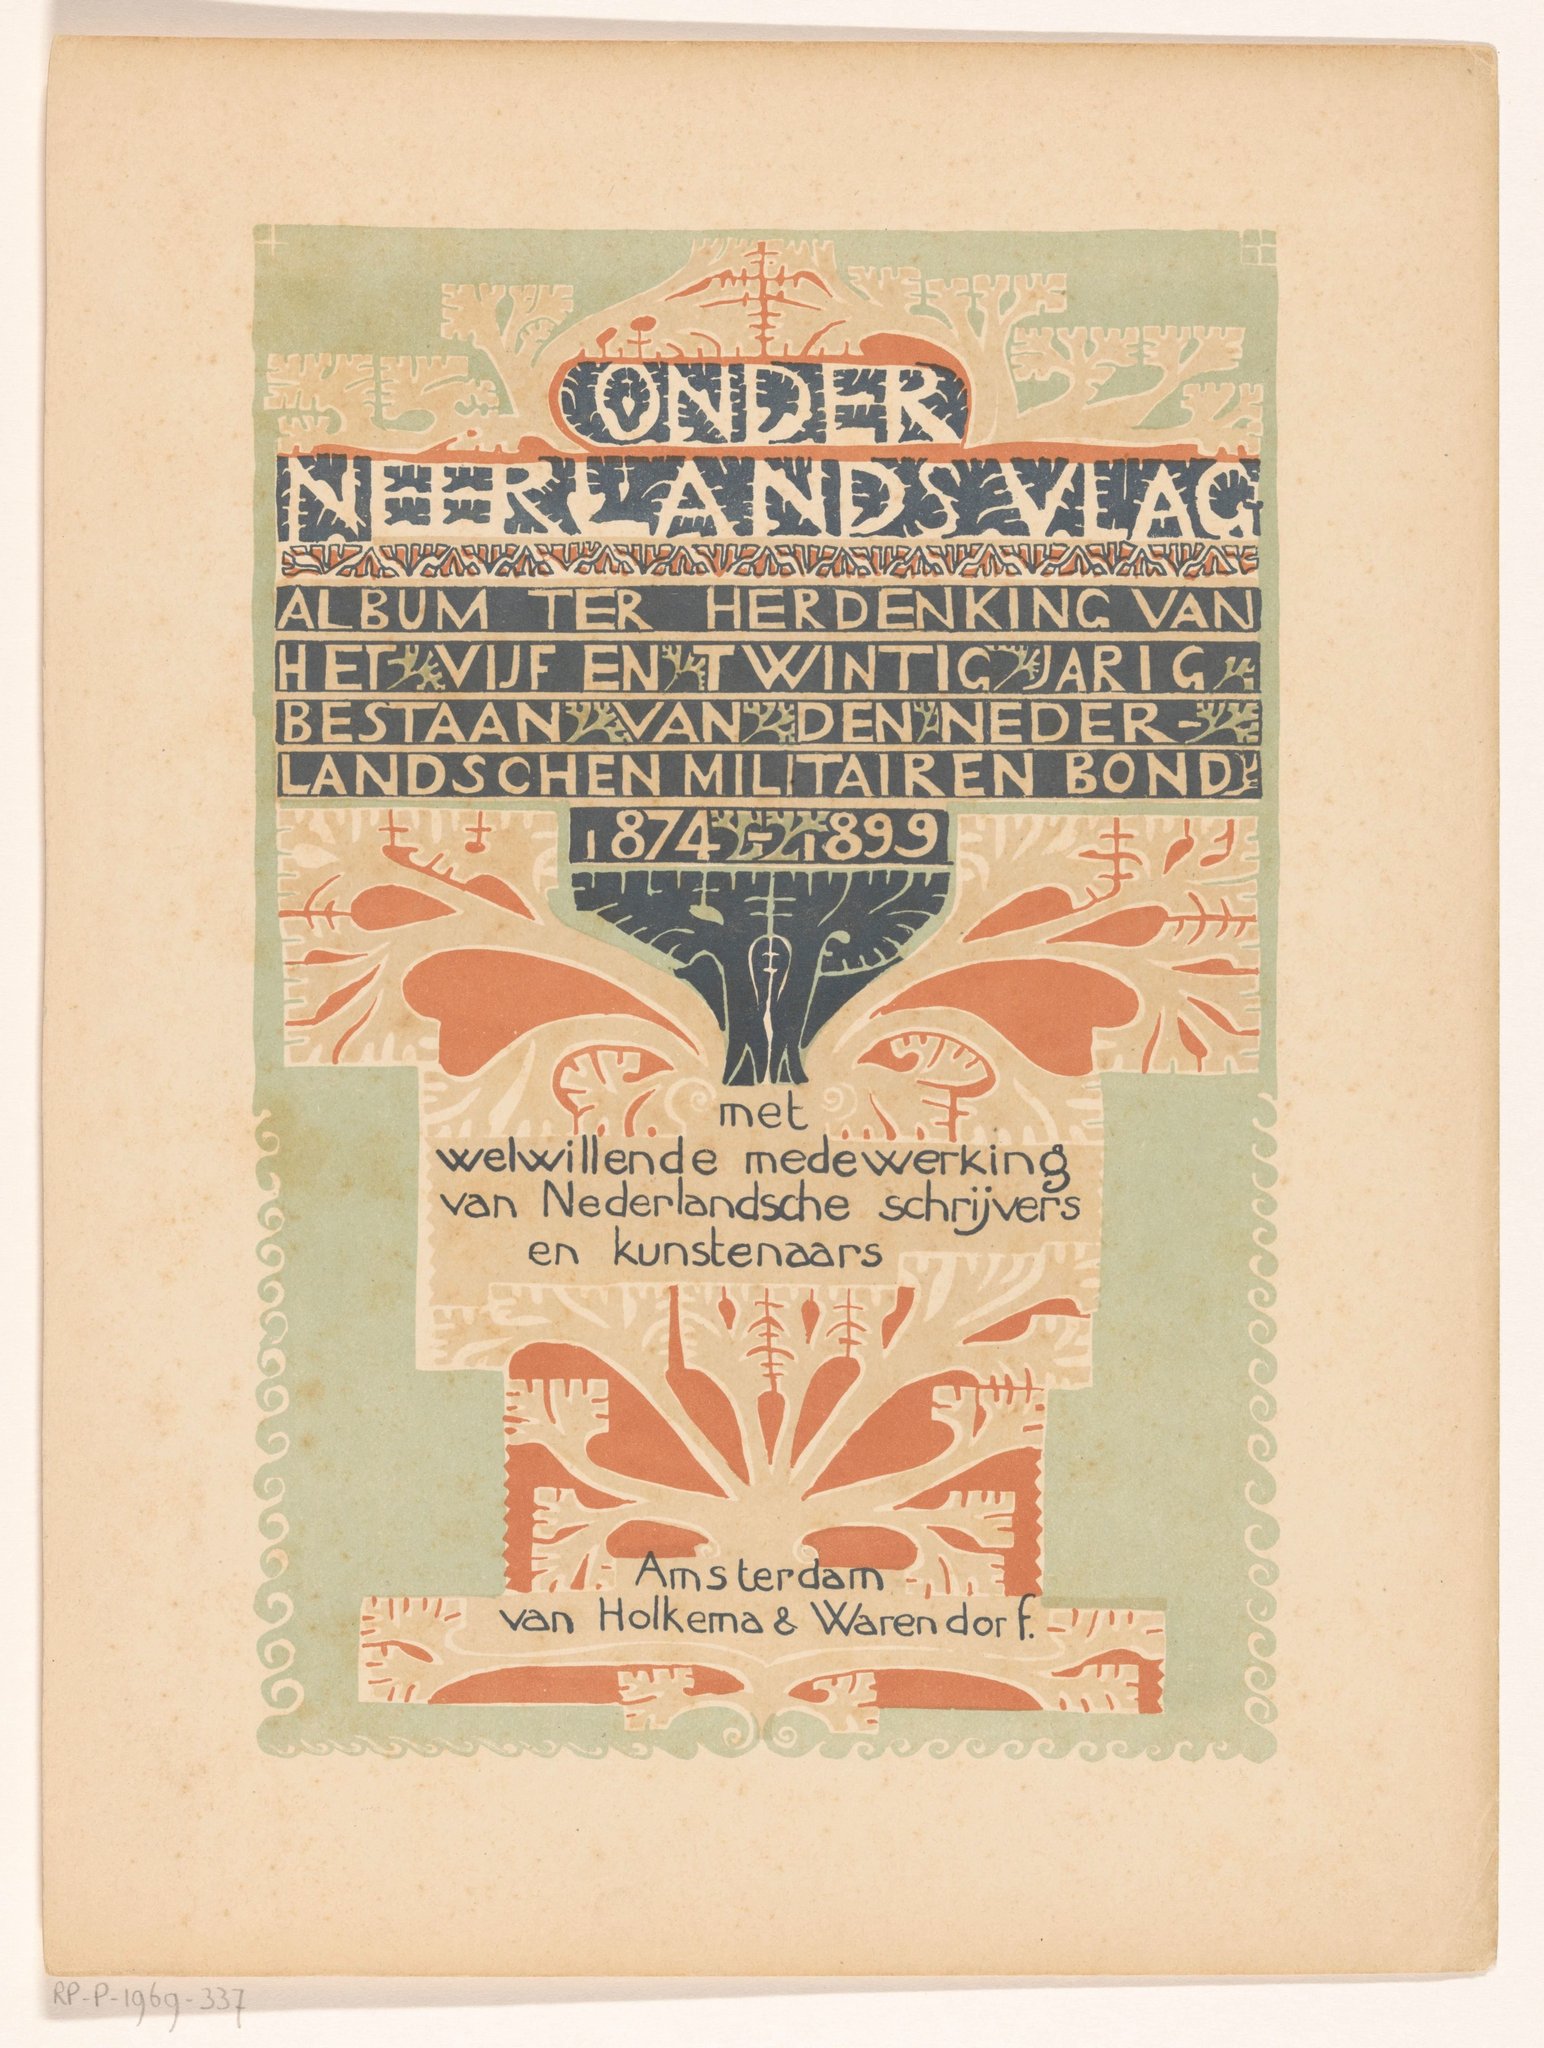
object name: print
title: Titelpagina voor: Onder Neerlands vlag, 1899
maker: carel adolph lion cachet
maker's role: draughtsman, print maker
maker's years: 1864-1945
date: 1899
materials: paper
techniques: lithograph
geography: amsterdam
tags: foliage, tendrils, branches ~ ornament - aa - stylized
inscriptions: collector's mark: Lugt 2228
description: Prent mogelijk gebruikt voor: Onder Neerlands vlag. Album ter herdenking van het vijf en twintig jarig bestaan van den Nederlandschen Militairen Bond 1874-1899. Amsterdam: Van Holkema & Warendorf, 1899.